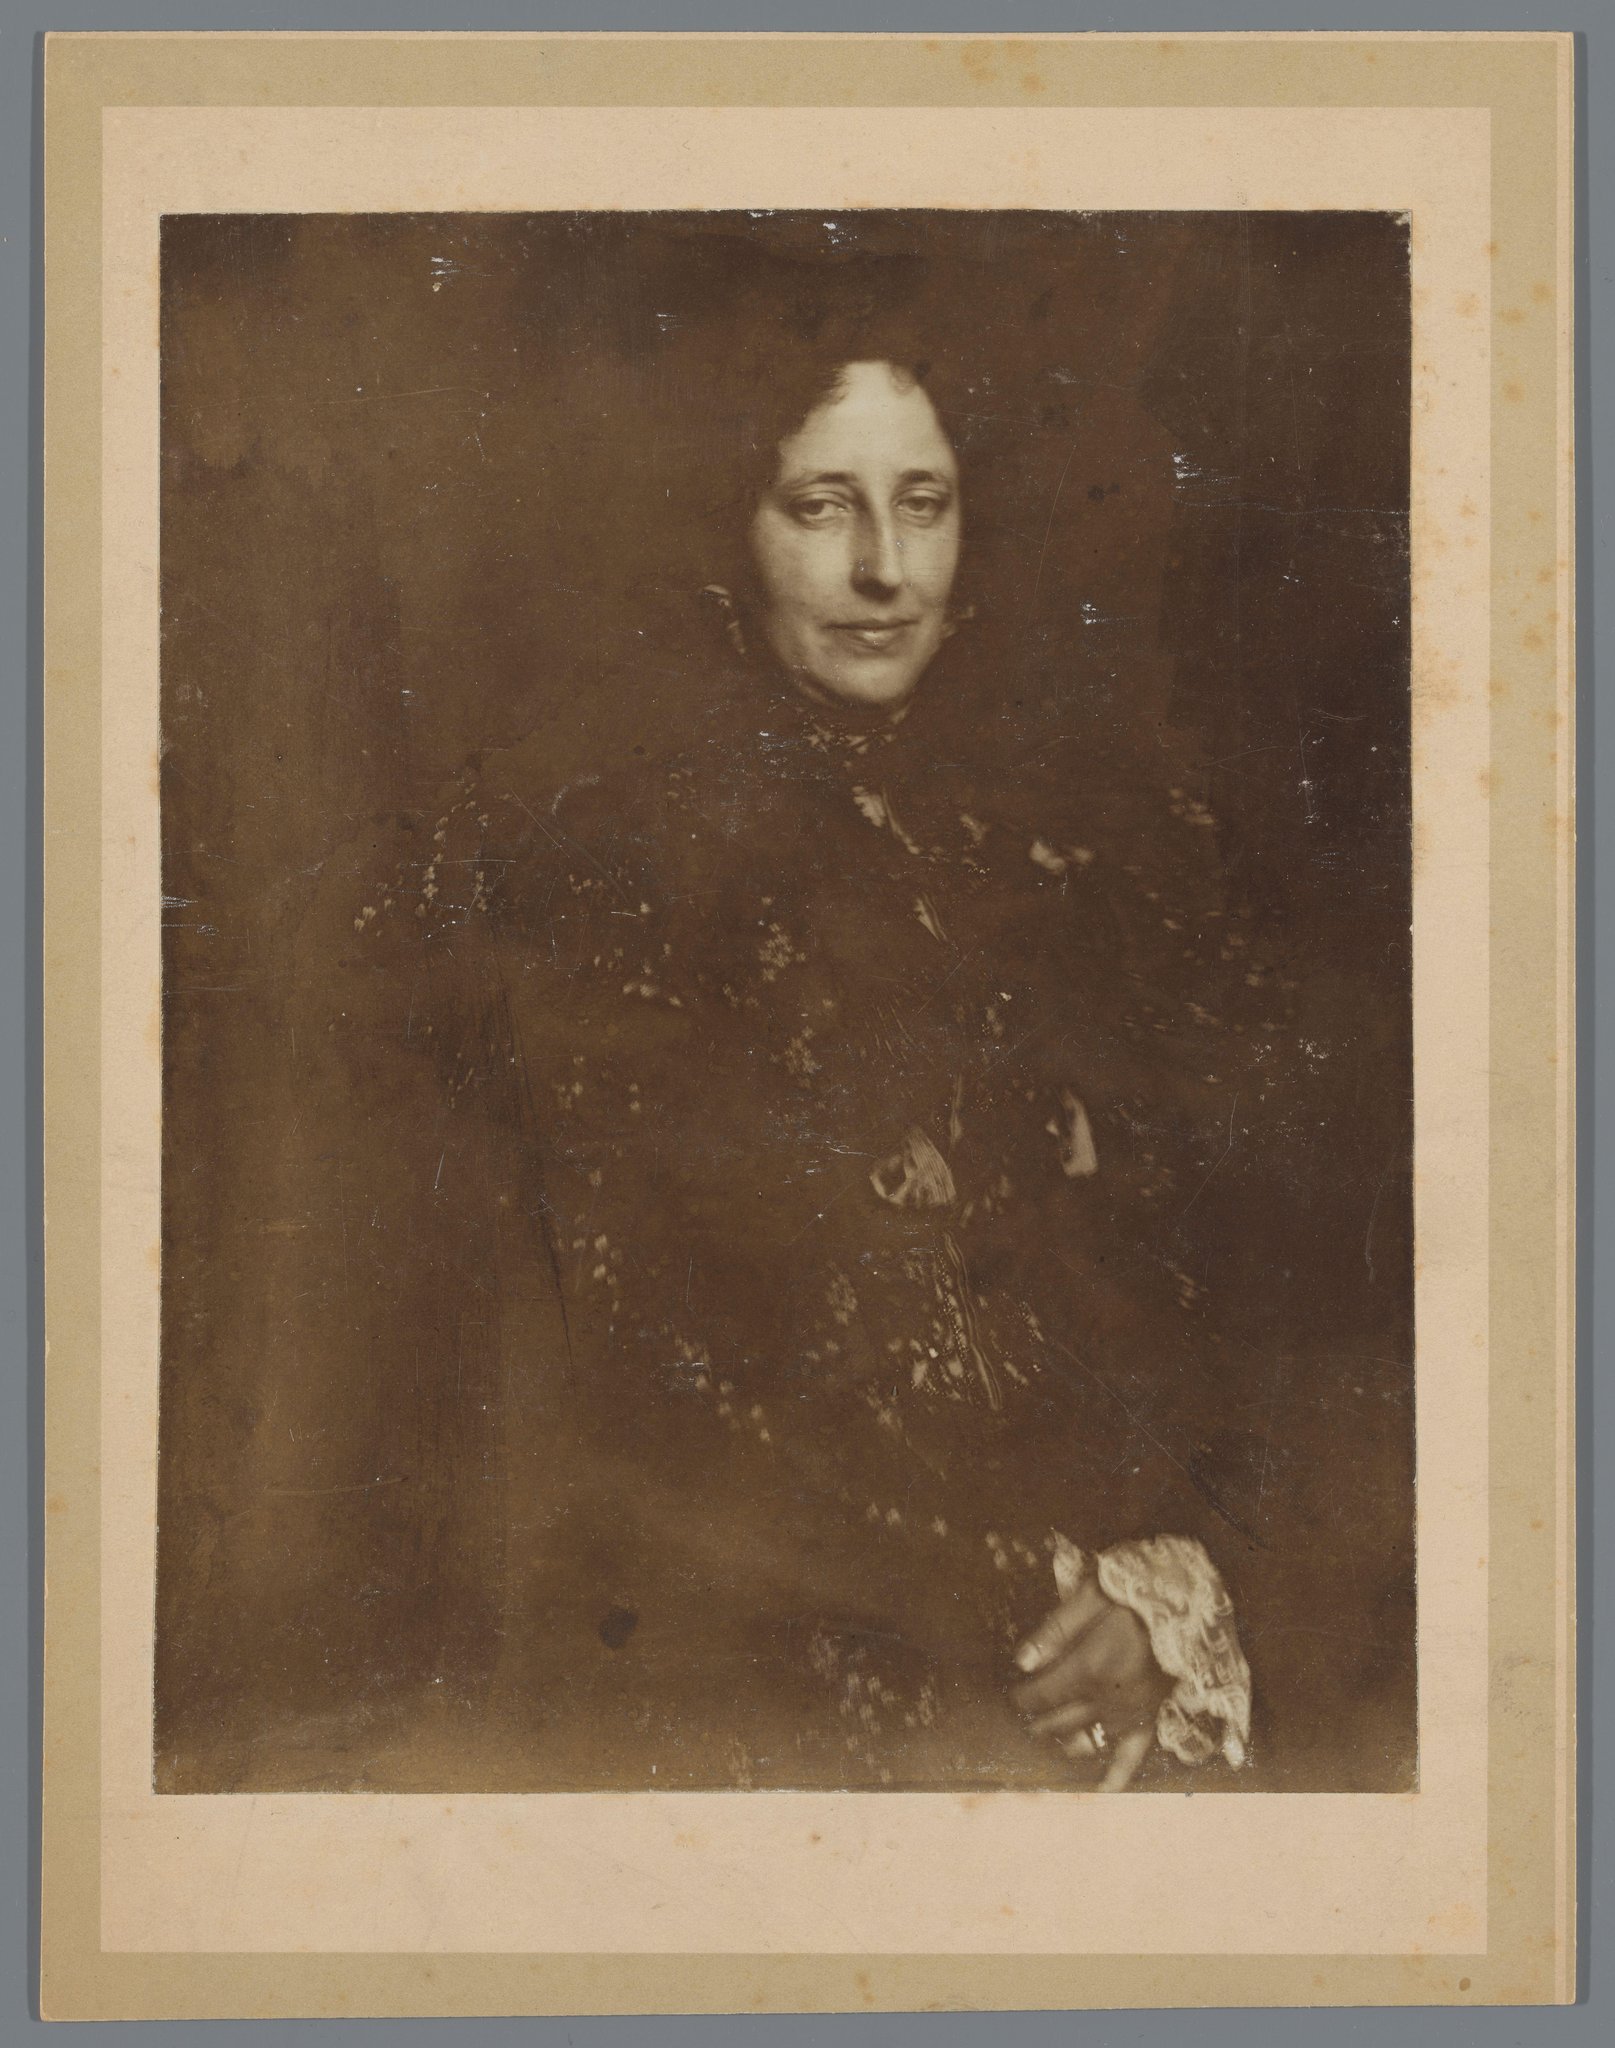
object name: photograph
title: Portret van Johanna Stam, de echtgenote van de schilder Herman van der Weele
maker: Anonymous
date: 1880-1900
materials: paper, cardboard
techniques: collodion silver print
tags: historical persons - bb - woman